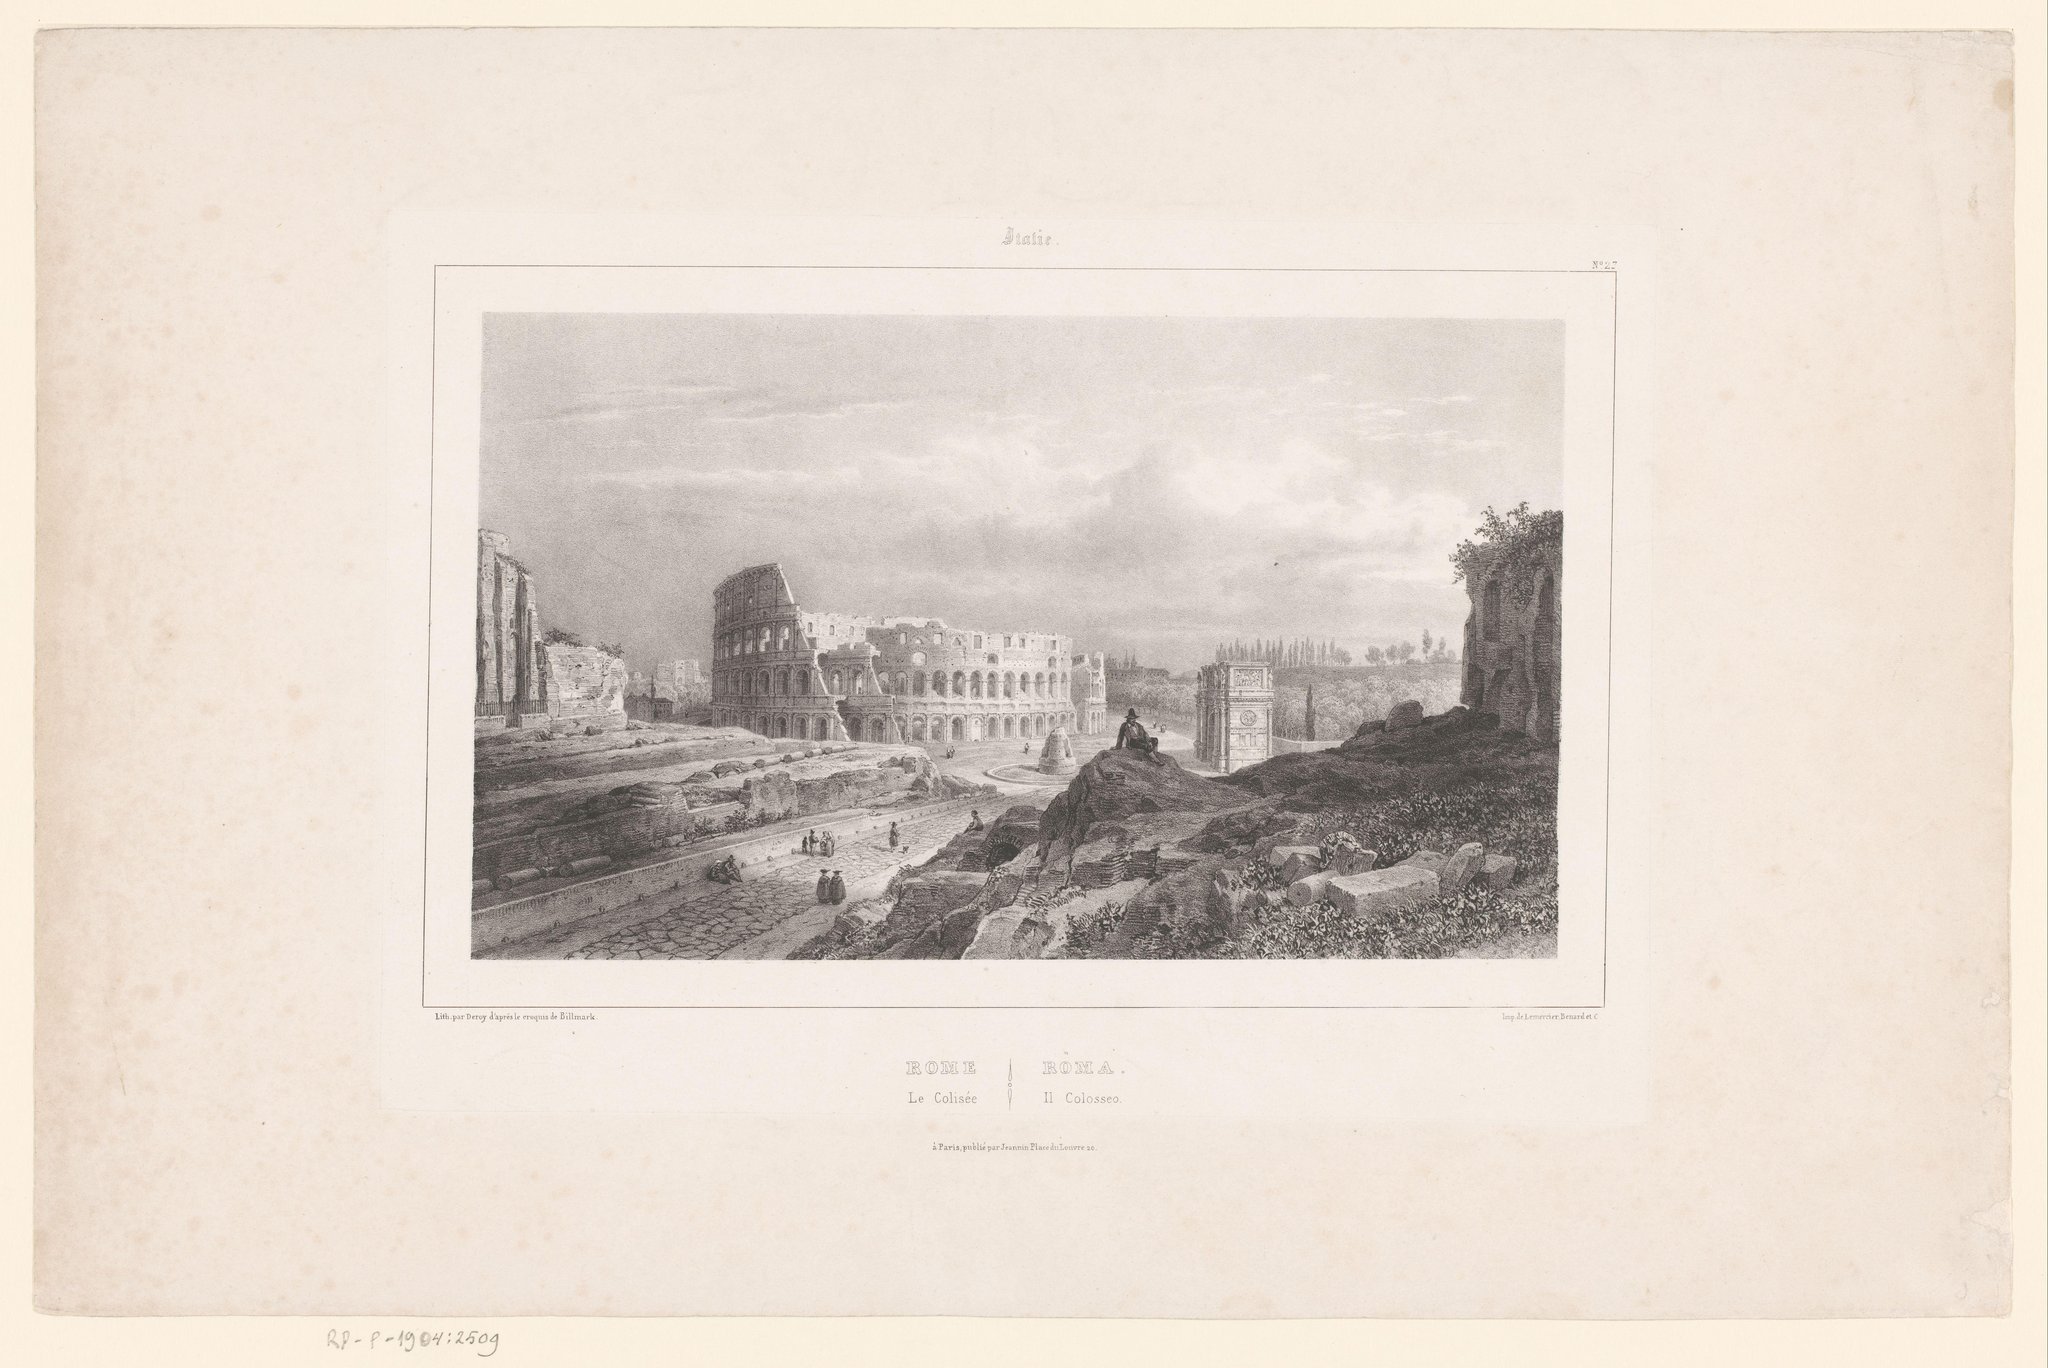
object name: print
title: Rome Roma / Le Colisée il Colosseo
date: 1837-1845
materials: paper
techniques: lithograph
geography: paris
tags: amphitheatre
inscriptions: collector's mark: Lugt 2228